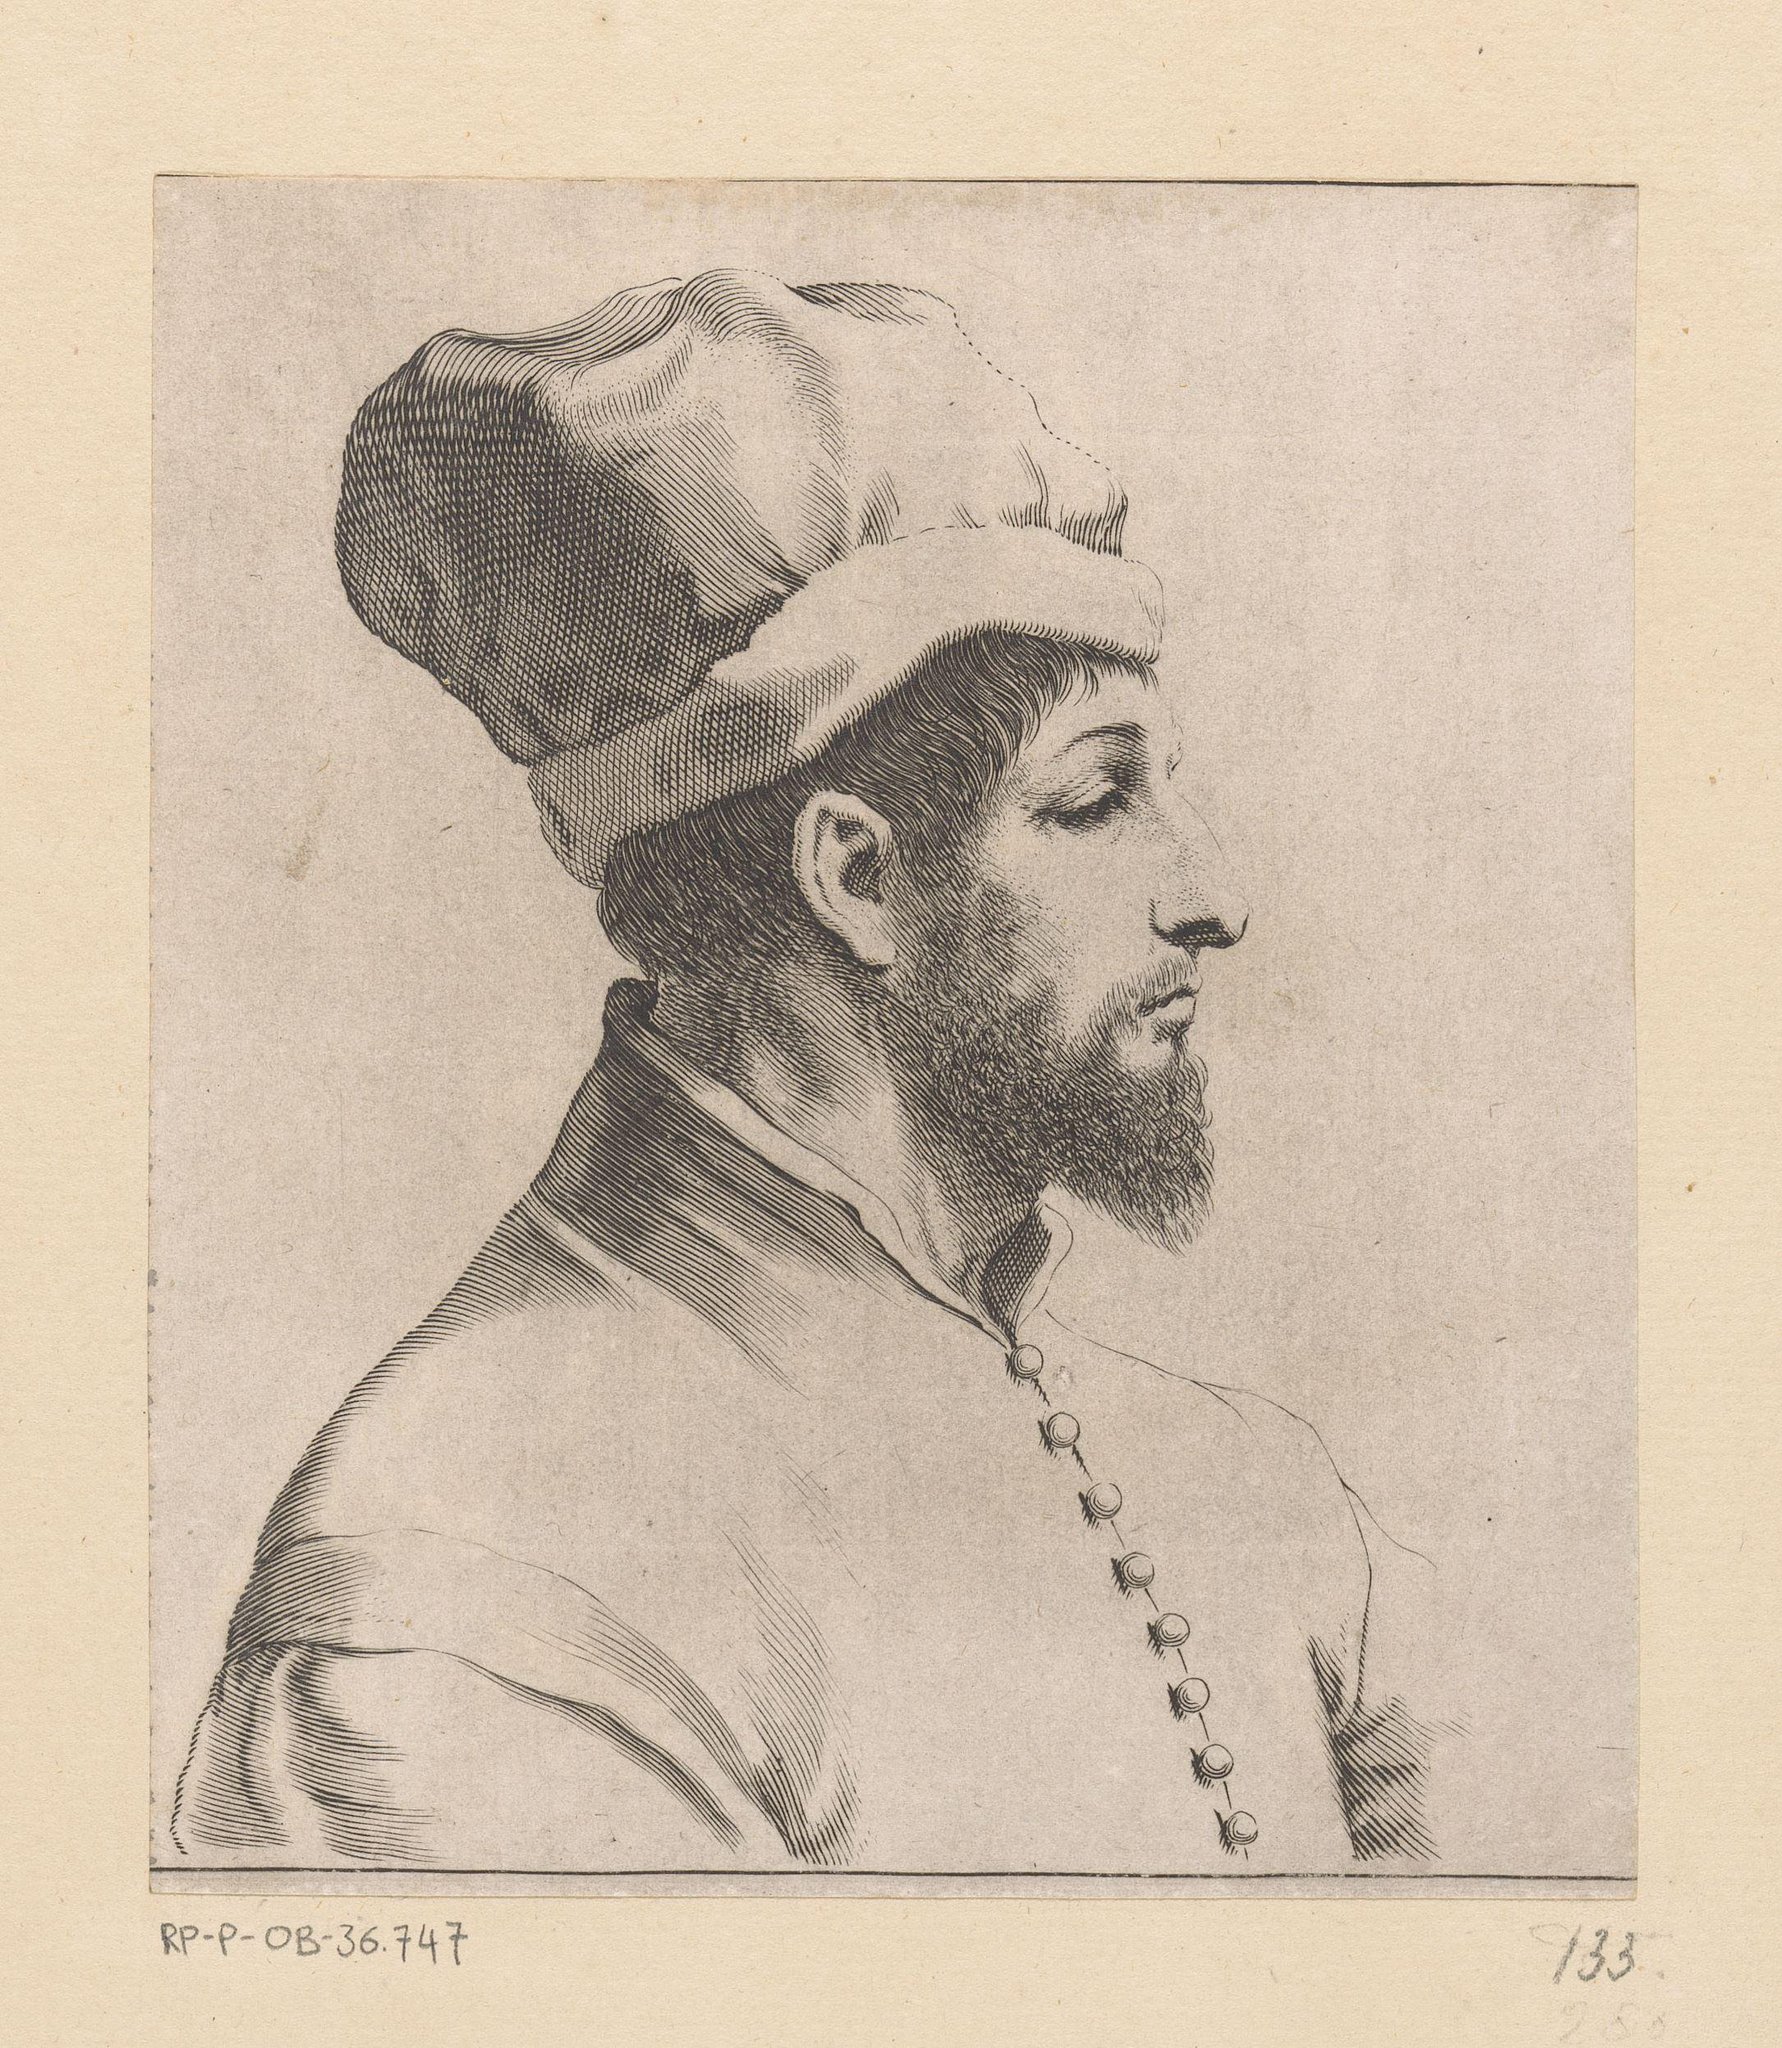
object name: print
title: Portret van een onbekende man met hoed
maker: Anonymous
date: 1600-1699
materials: paper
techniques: engraving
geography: italy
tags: head-gear: cap (+ men's clothes), historical persons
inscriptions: collector's mark: Lugt 240